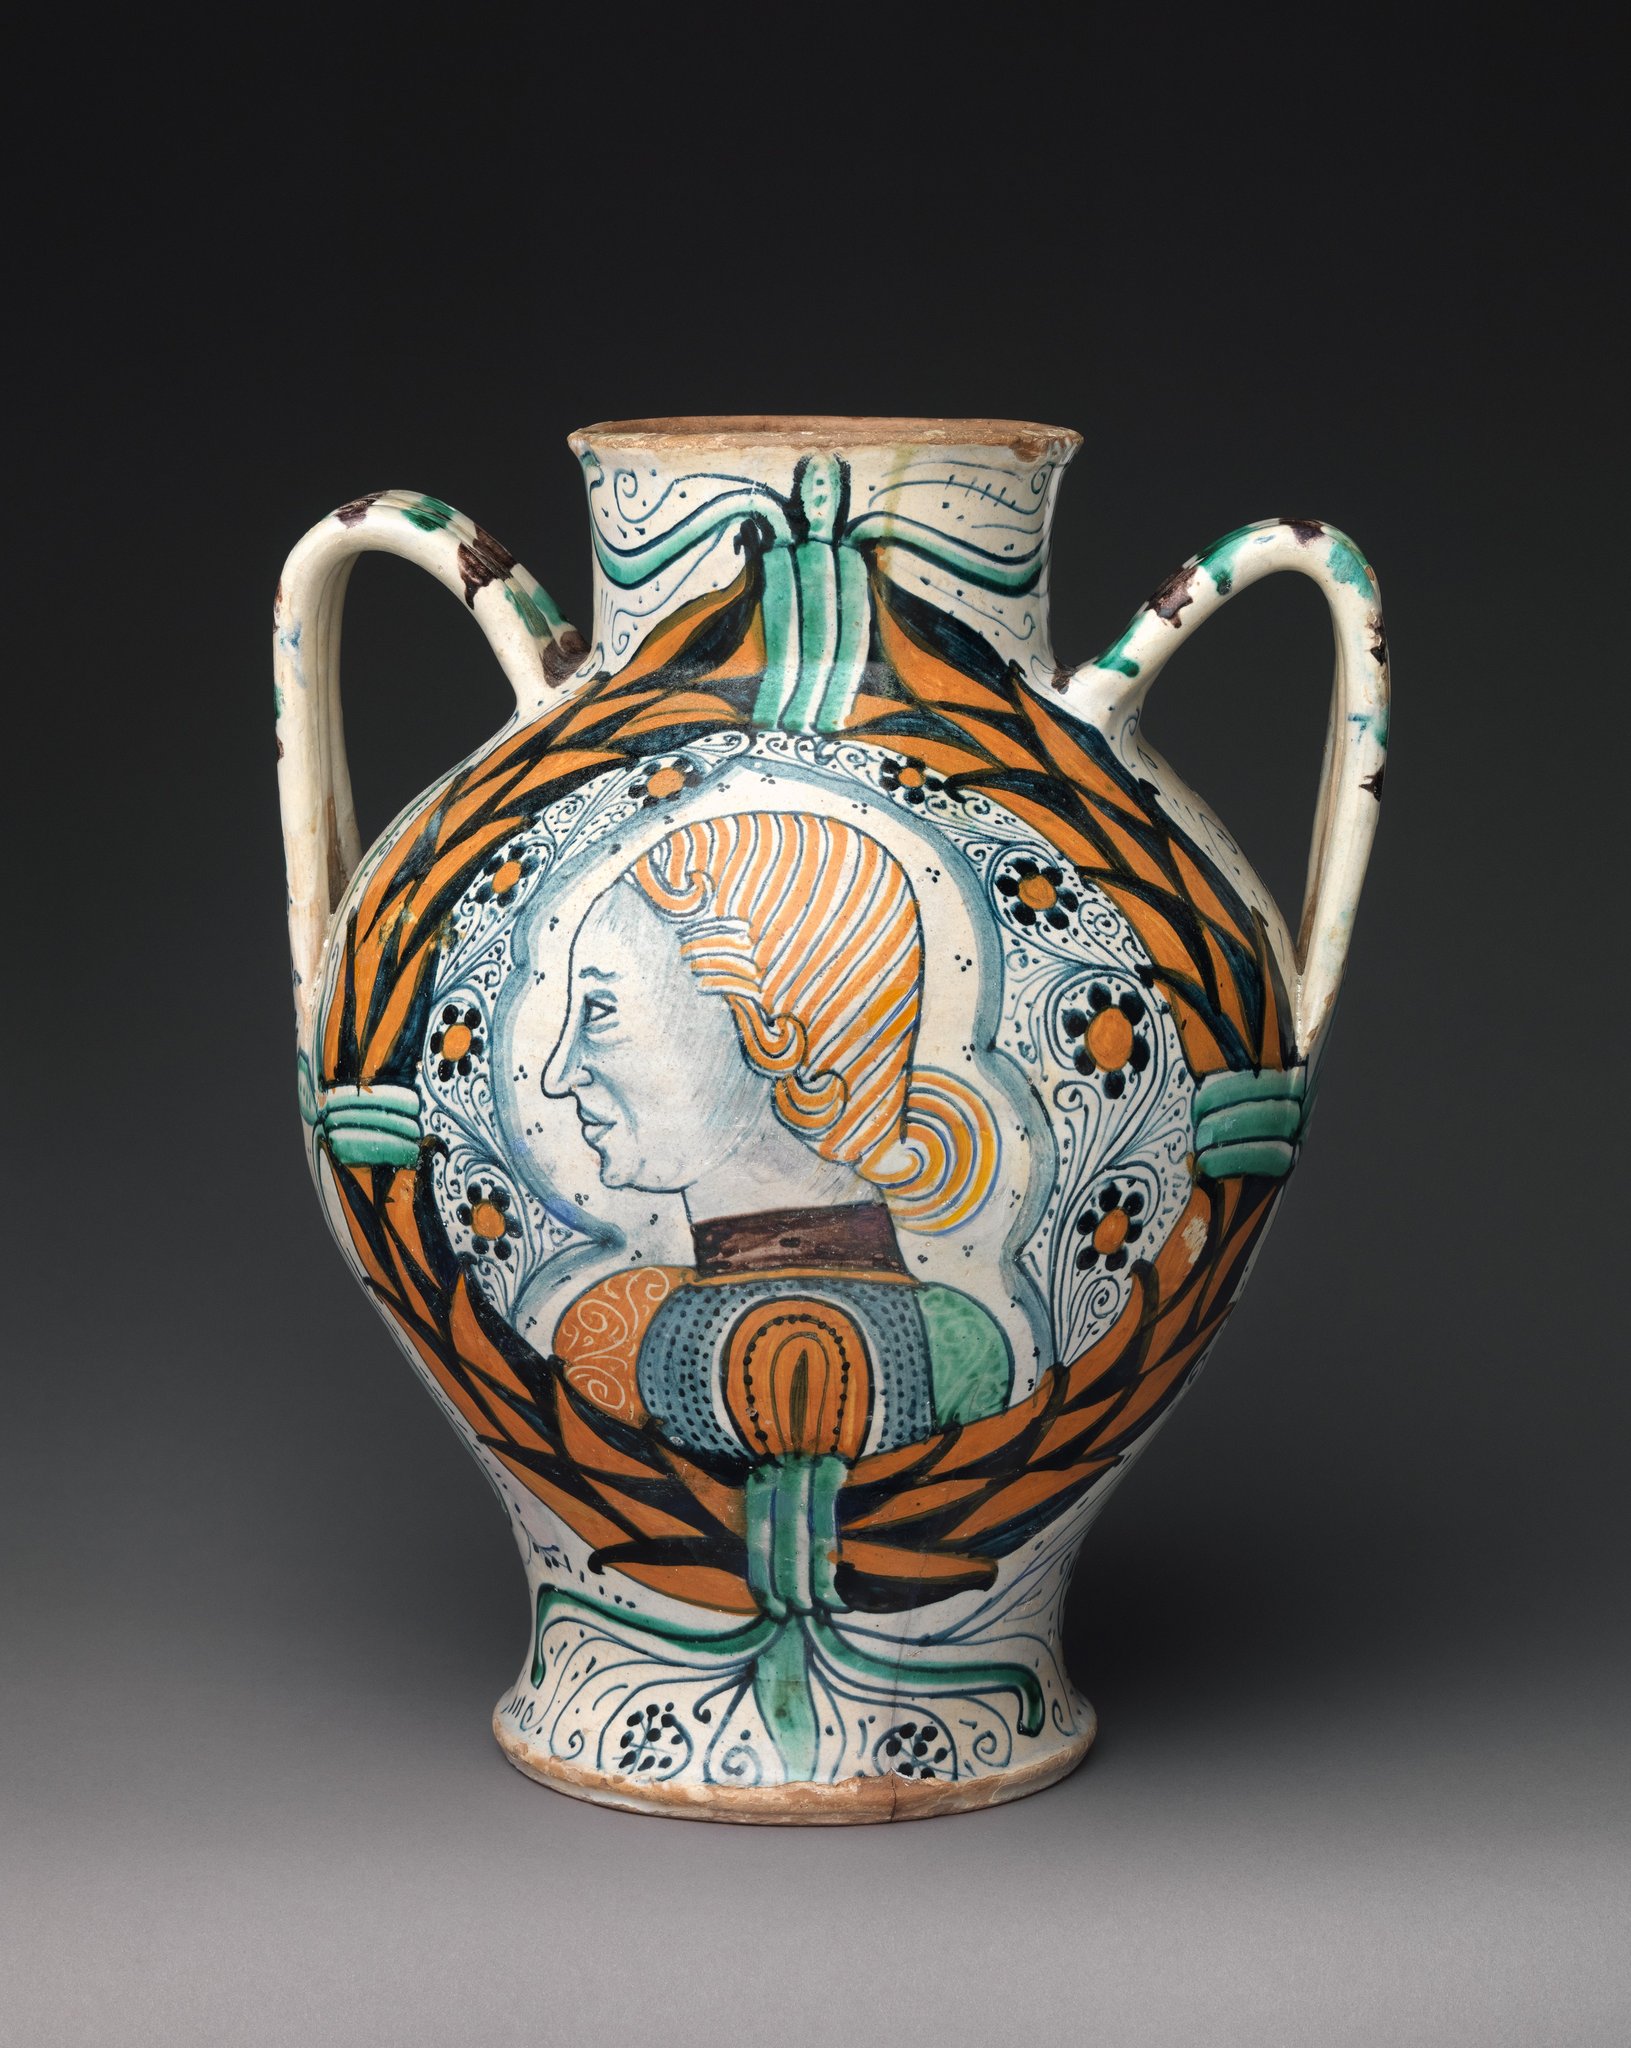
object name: storage or pharmacy jar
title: Two-handled pharmacy or storage jar with arms of the Orsini family and profile head of a man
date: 1460-1480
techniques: maiolica, glazing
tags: profiles,women,coat of arms